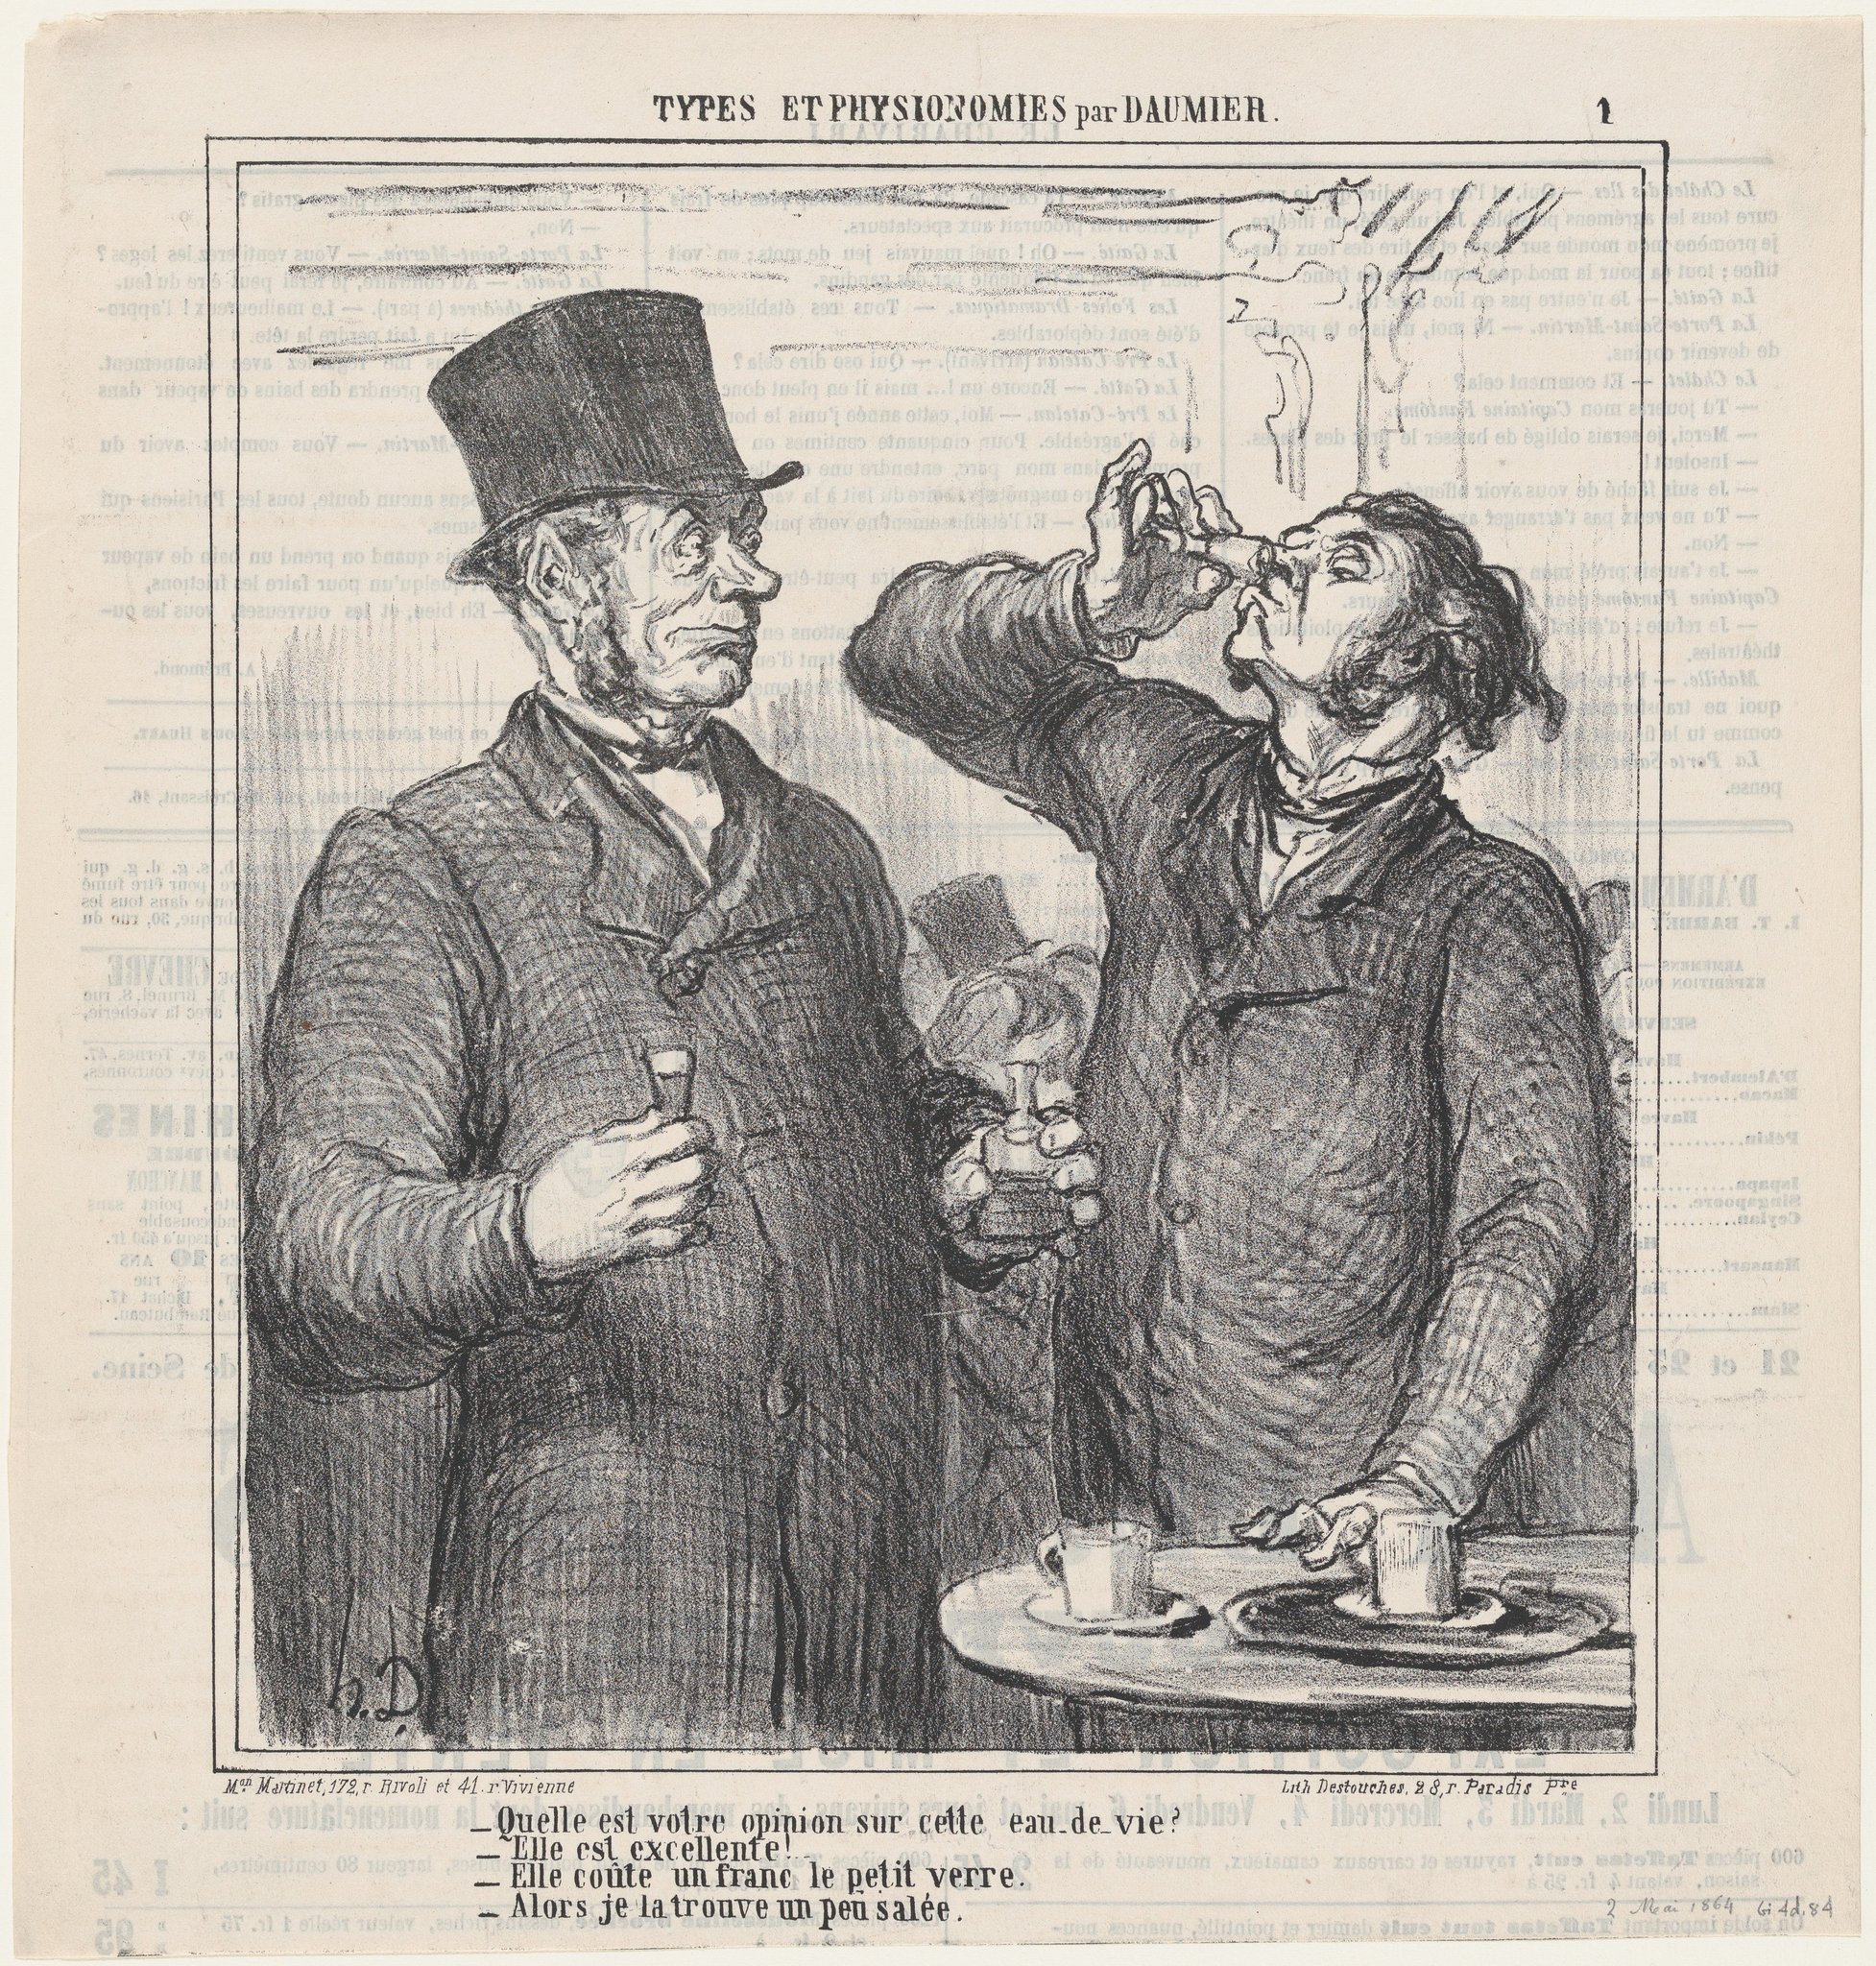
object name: print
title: What's your opinion of this brandy?, from 'Types and features,' published in Le Charivari, May 2, 1864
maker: honoré daumier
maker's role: artist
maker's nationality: french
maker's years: 1808-1879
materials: paper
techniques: lithograph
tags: men,drinking